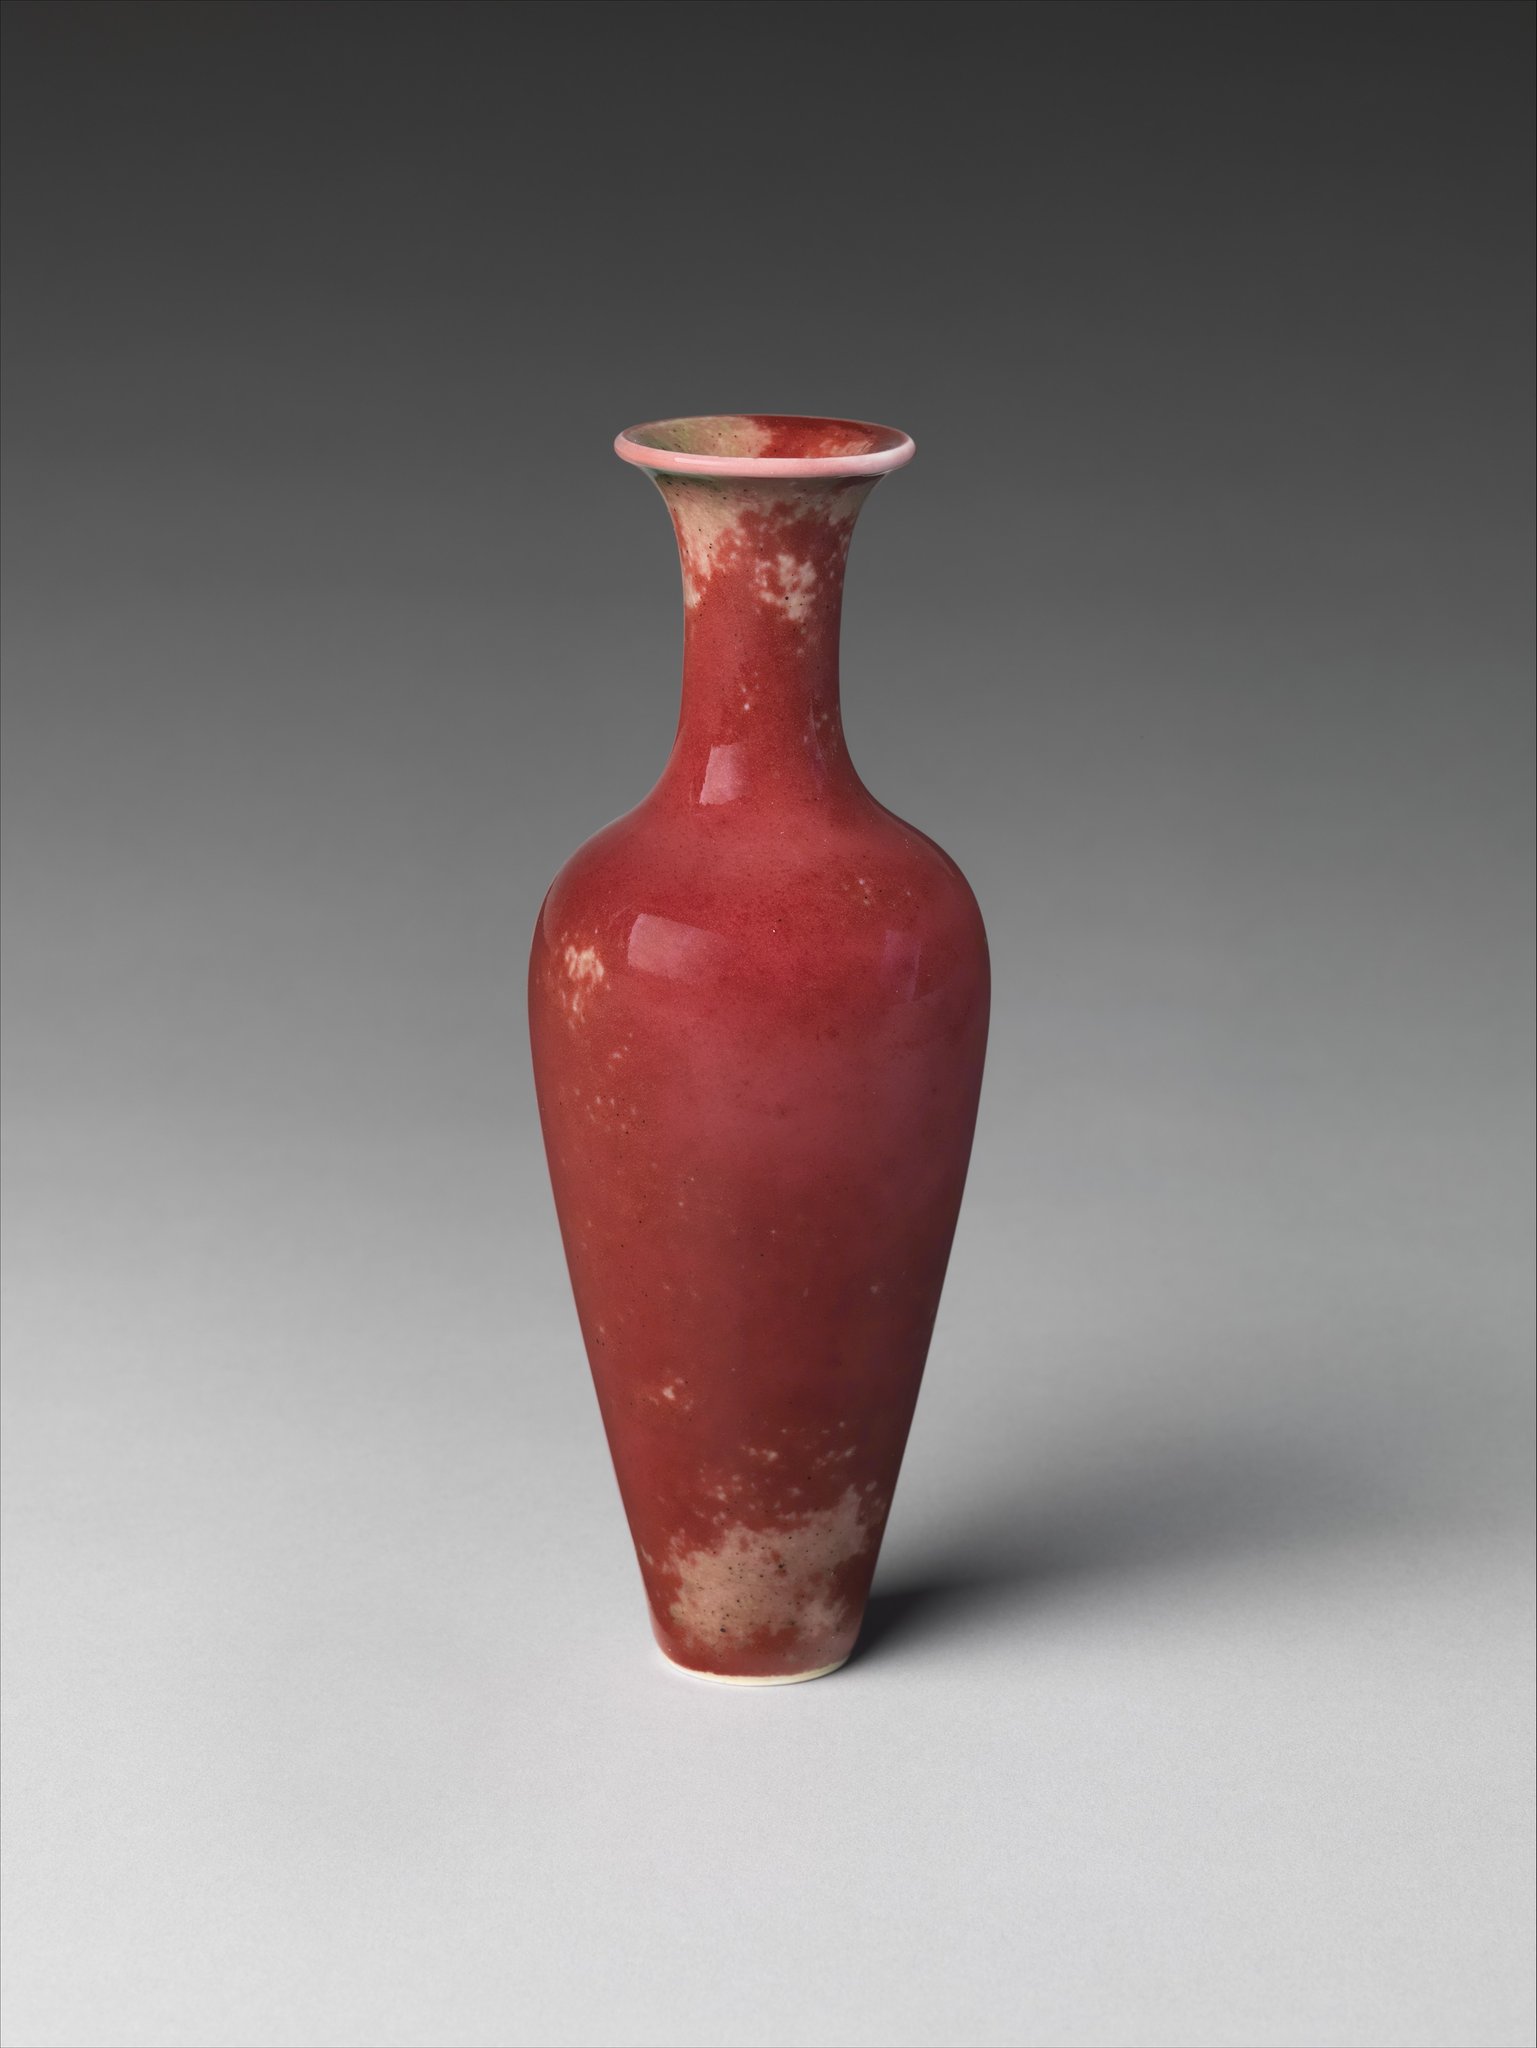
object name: vase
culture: chinese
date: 1662-1722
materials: glaze, porcelain